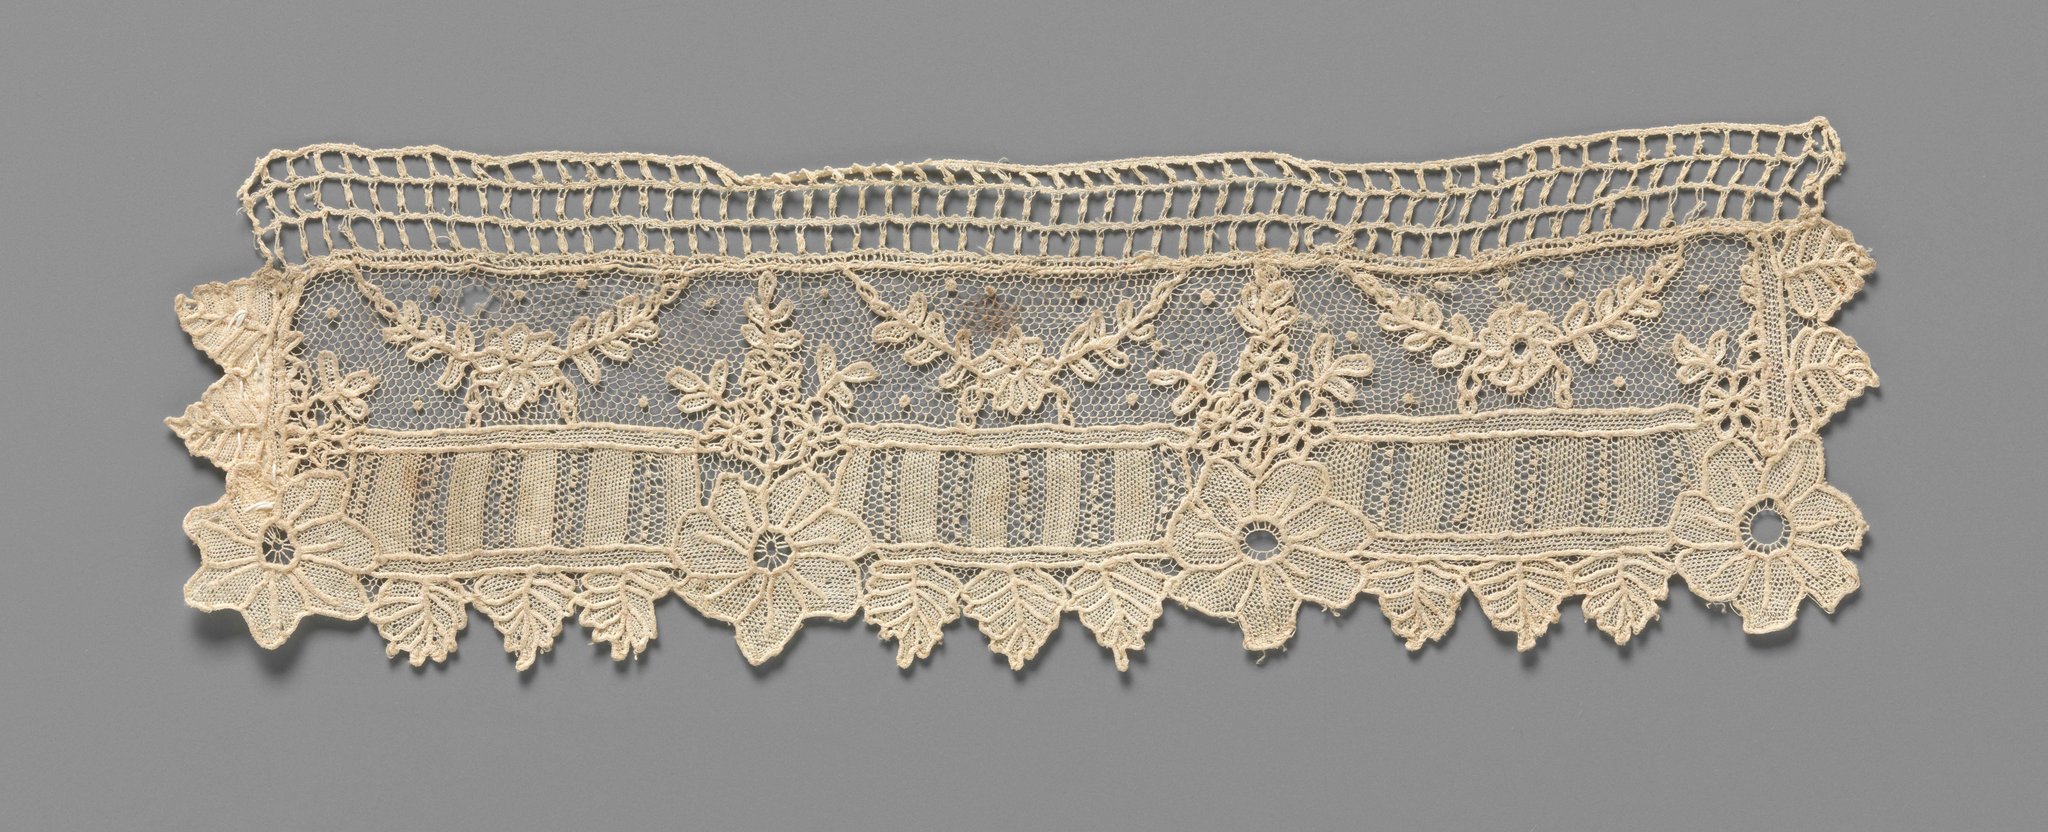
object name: womenswear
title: Manchet van naaldkant met een rechte sierband met verticale strepen en drie eenvoudige bloemslingers van blaadjes en op het laagste punt steeds één rozetbloempje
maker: Anonymous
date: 1880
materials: linen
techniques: lace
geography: brussels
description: Manchet van naturelkleurige naaldkant: Brusselse gaaskant. Rechthoekig model met een geschulpte blaadjesrand en een recht geklost bandje met een vierkant raster langs de bovenkant. Symmetrisch patroon met een rechte sierband met verticale strepen waarboven drie eenvoudige bloemslingers naast elkaar, met blaadjes en op het laagste punt steeds één rozetbloempje. De sierband met strepen wordt op de hoeken en in het midden oversneden door in totaal vier rozetbloemen, waarvan de onderkant een deel van de schulpenrand vormt. Deze rozetbloemen worden aan de bovenkant bekroond door drie rozetbloempjes en enkele bladtakjes die tussen de opeenvolgende bloemslingers doorsteken tot aan de bovenrand. De motieven zijn gemaakt met festonsteken en voorzien van reliëfcontouren van wijd gefestonneerde draadbundeltjes. De bloemslingers zijn met elkaar verbonden door een zeer fijne gaaskantgrond bezaaid met moesjes. In de bloemharten zijn enkele siersteken toegepast. De schulpenrand bestaat tussen de rozetbloemen uit drie hangende blaadjes en langs de korte zijden uit twee van dergelijke blaadjes.